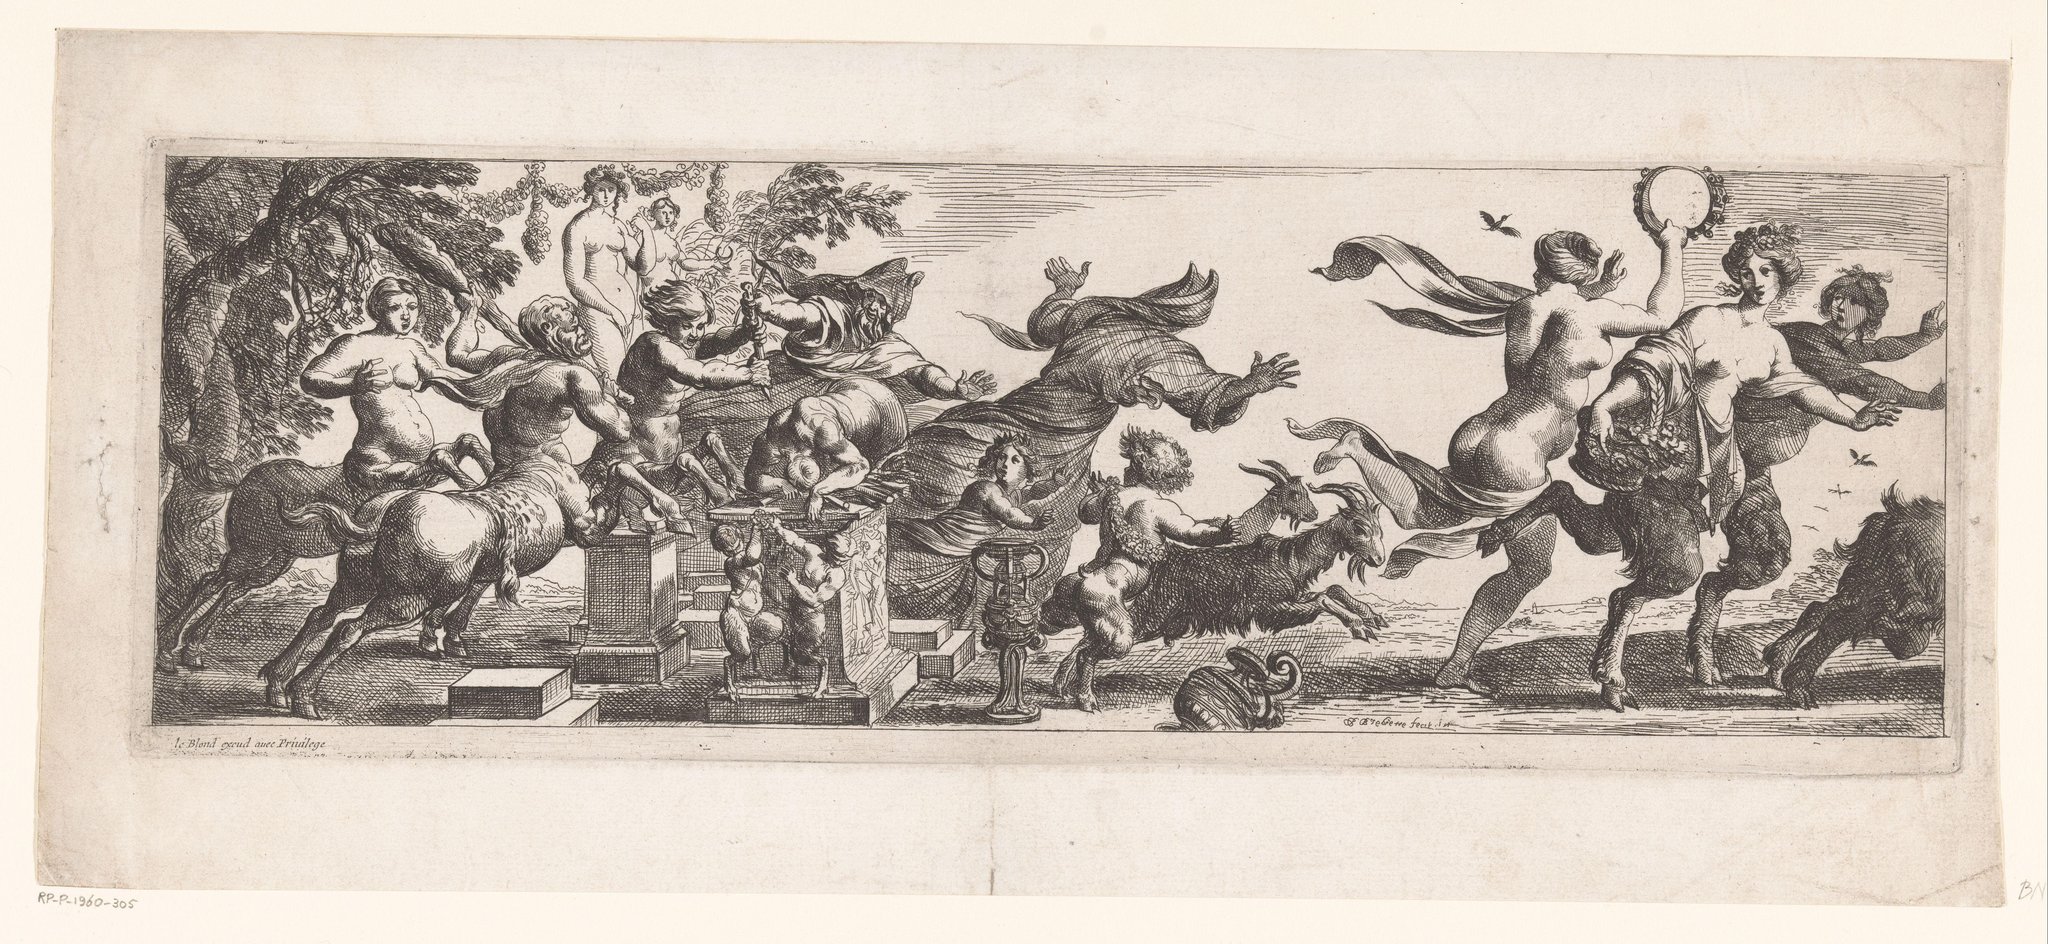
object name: print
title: Centauren verstoren een offerande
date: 1608-1650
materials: paper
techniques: etching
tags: priest ~ roman religion, priest ~ greek religion, centaurs (+ aggressive, unfriendly activities and relationships), sacrifice ~ non-christian religions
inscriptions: collector's mark: Lugt 2760, collector's mark: Lugt 2228